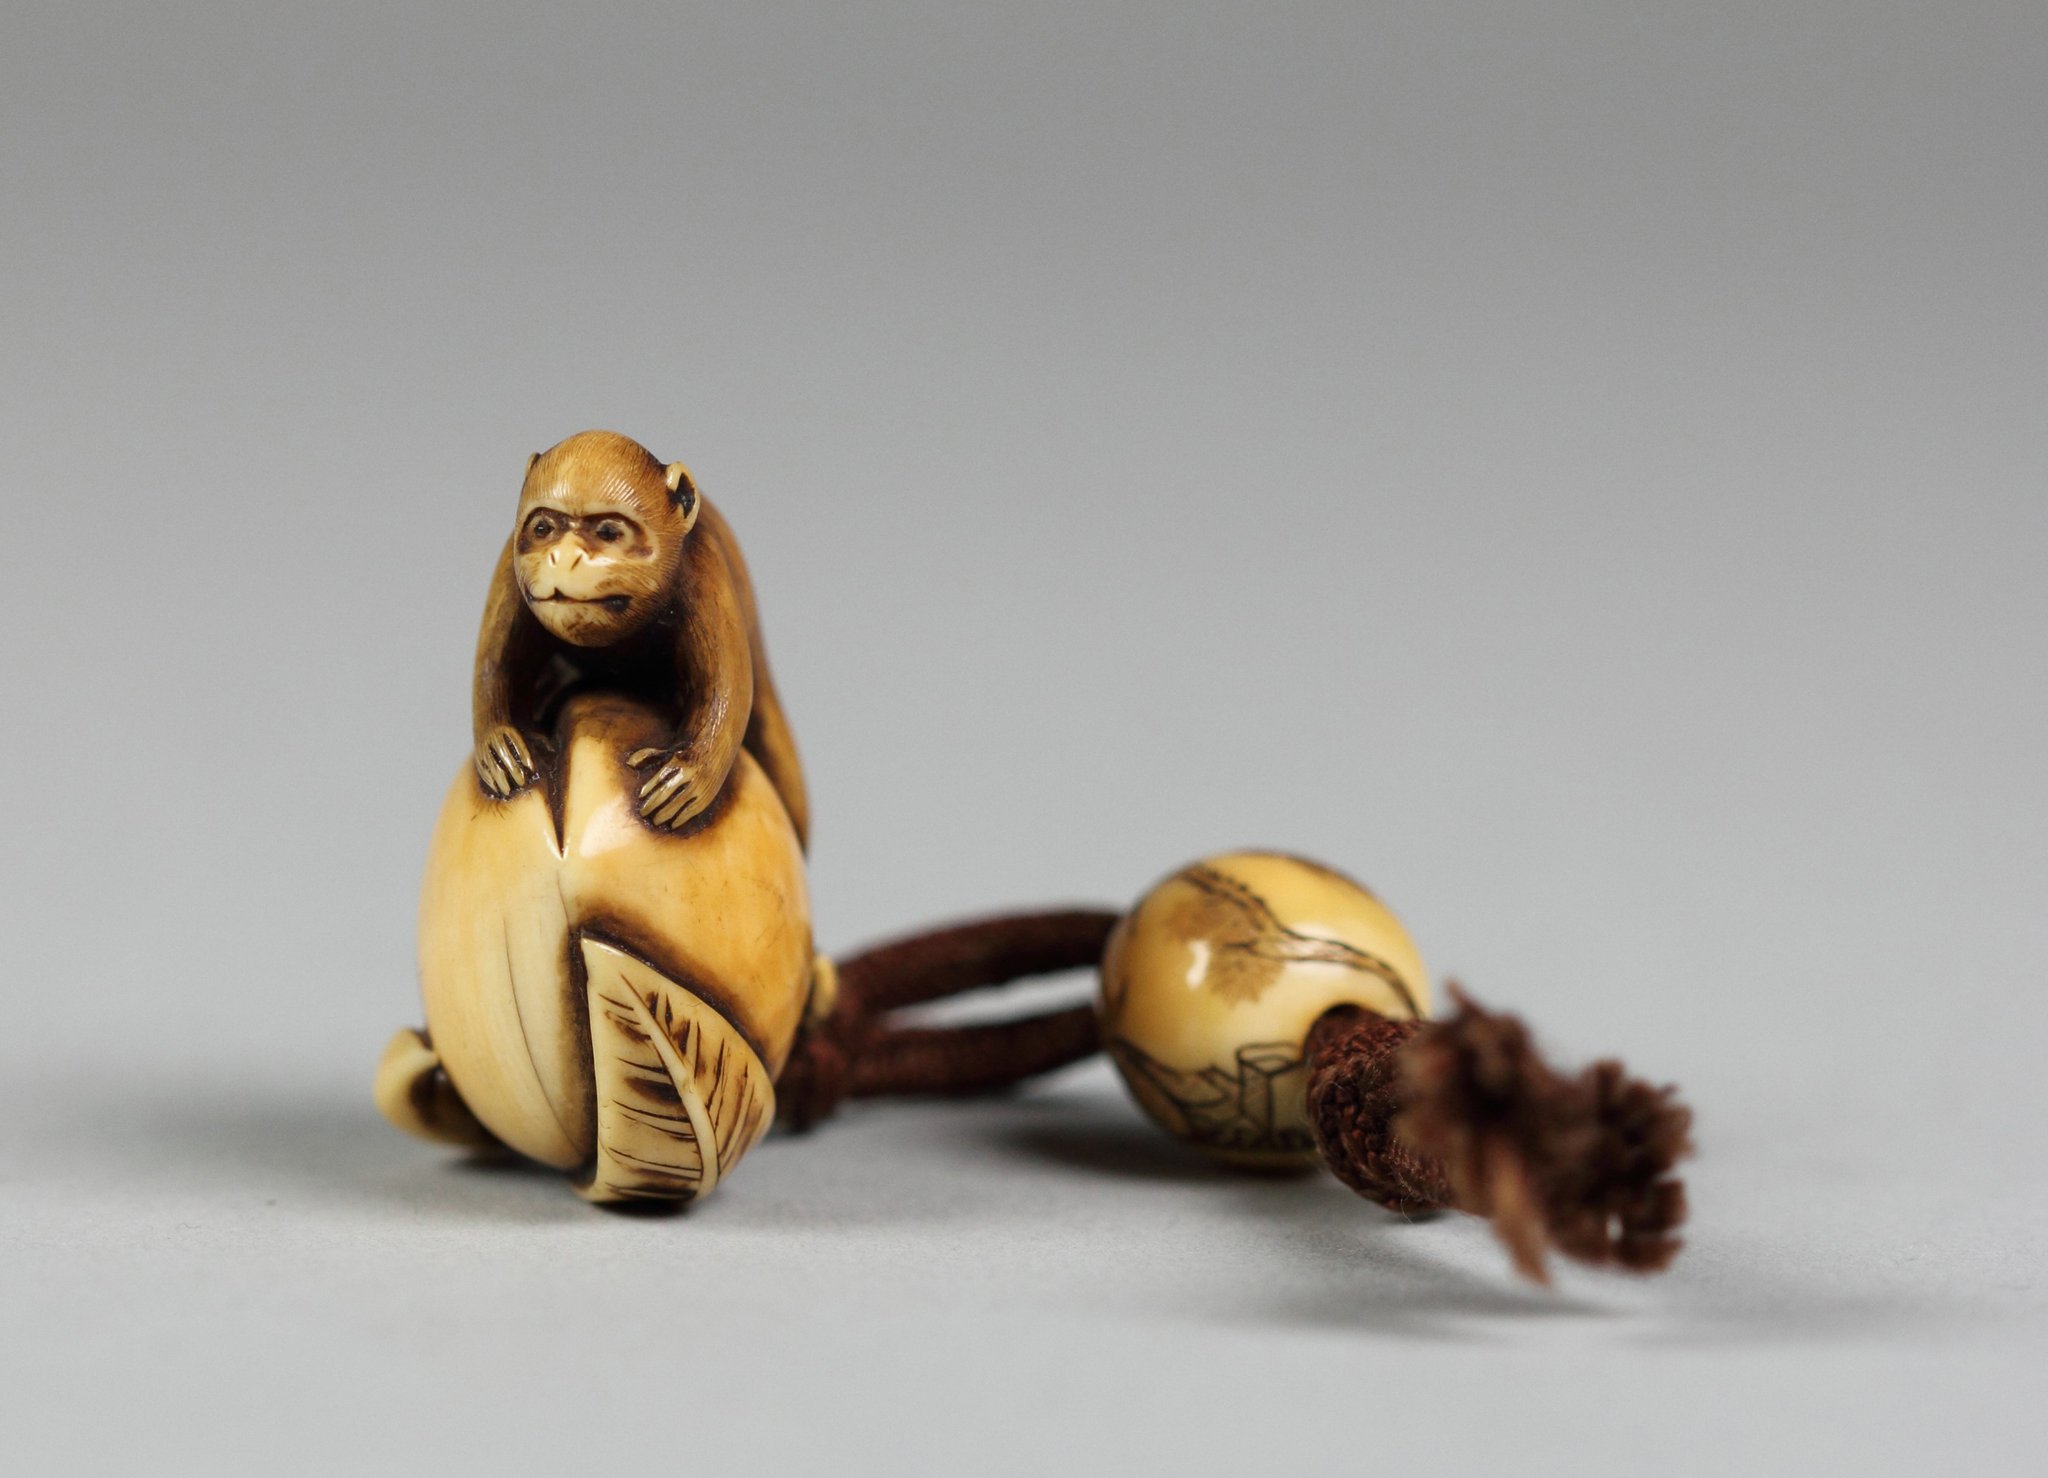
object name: netsuke and slide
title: Netsuke of Monkey on Peach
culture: japanese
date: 1701-1800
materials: ivory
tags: peaches